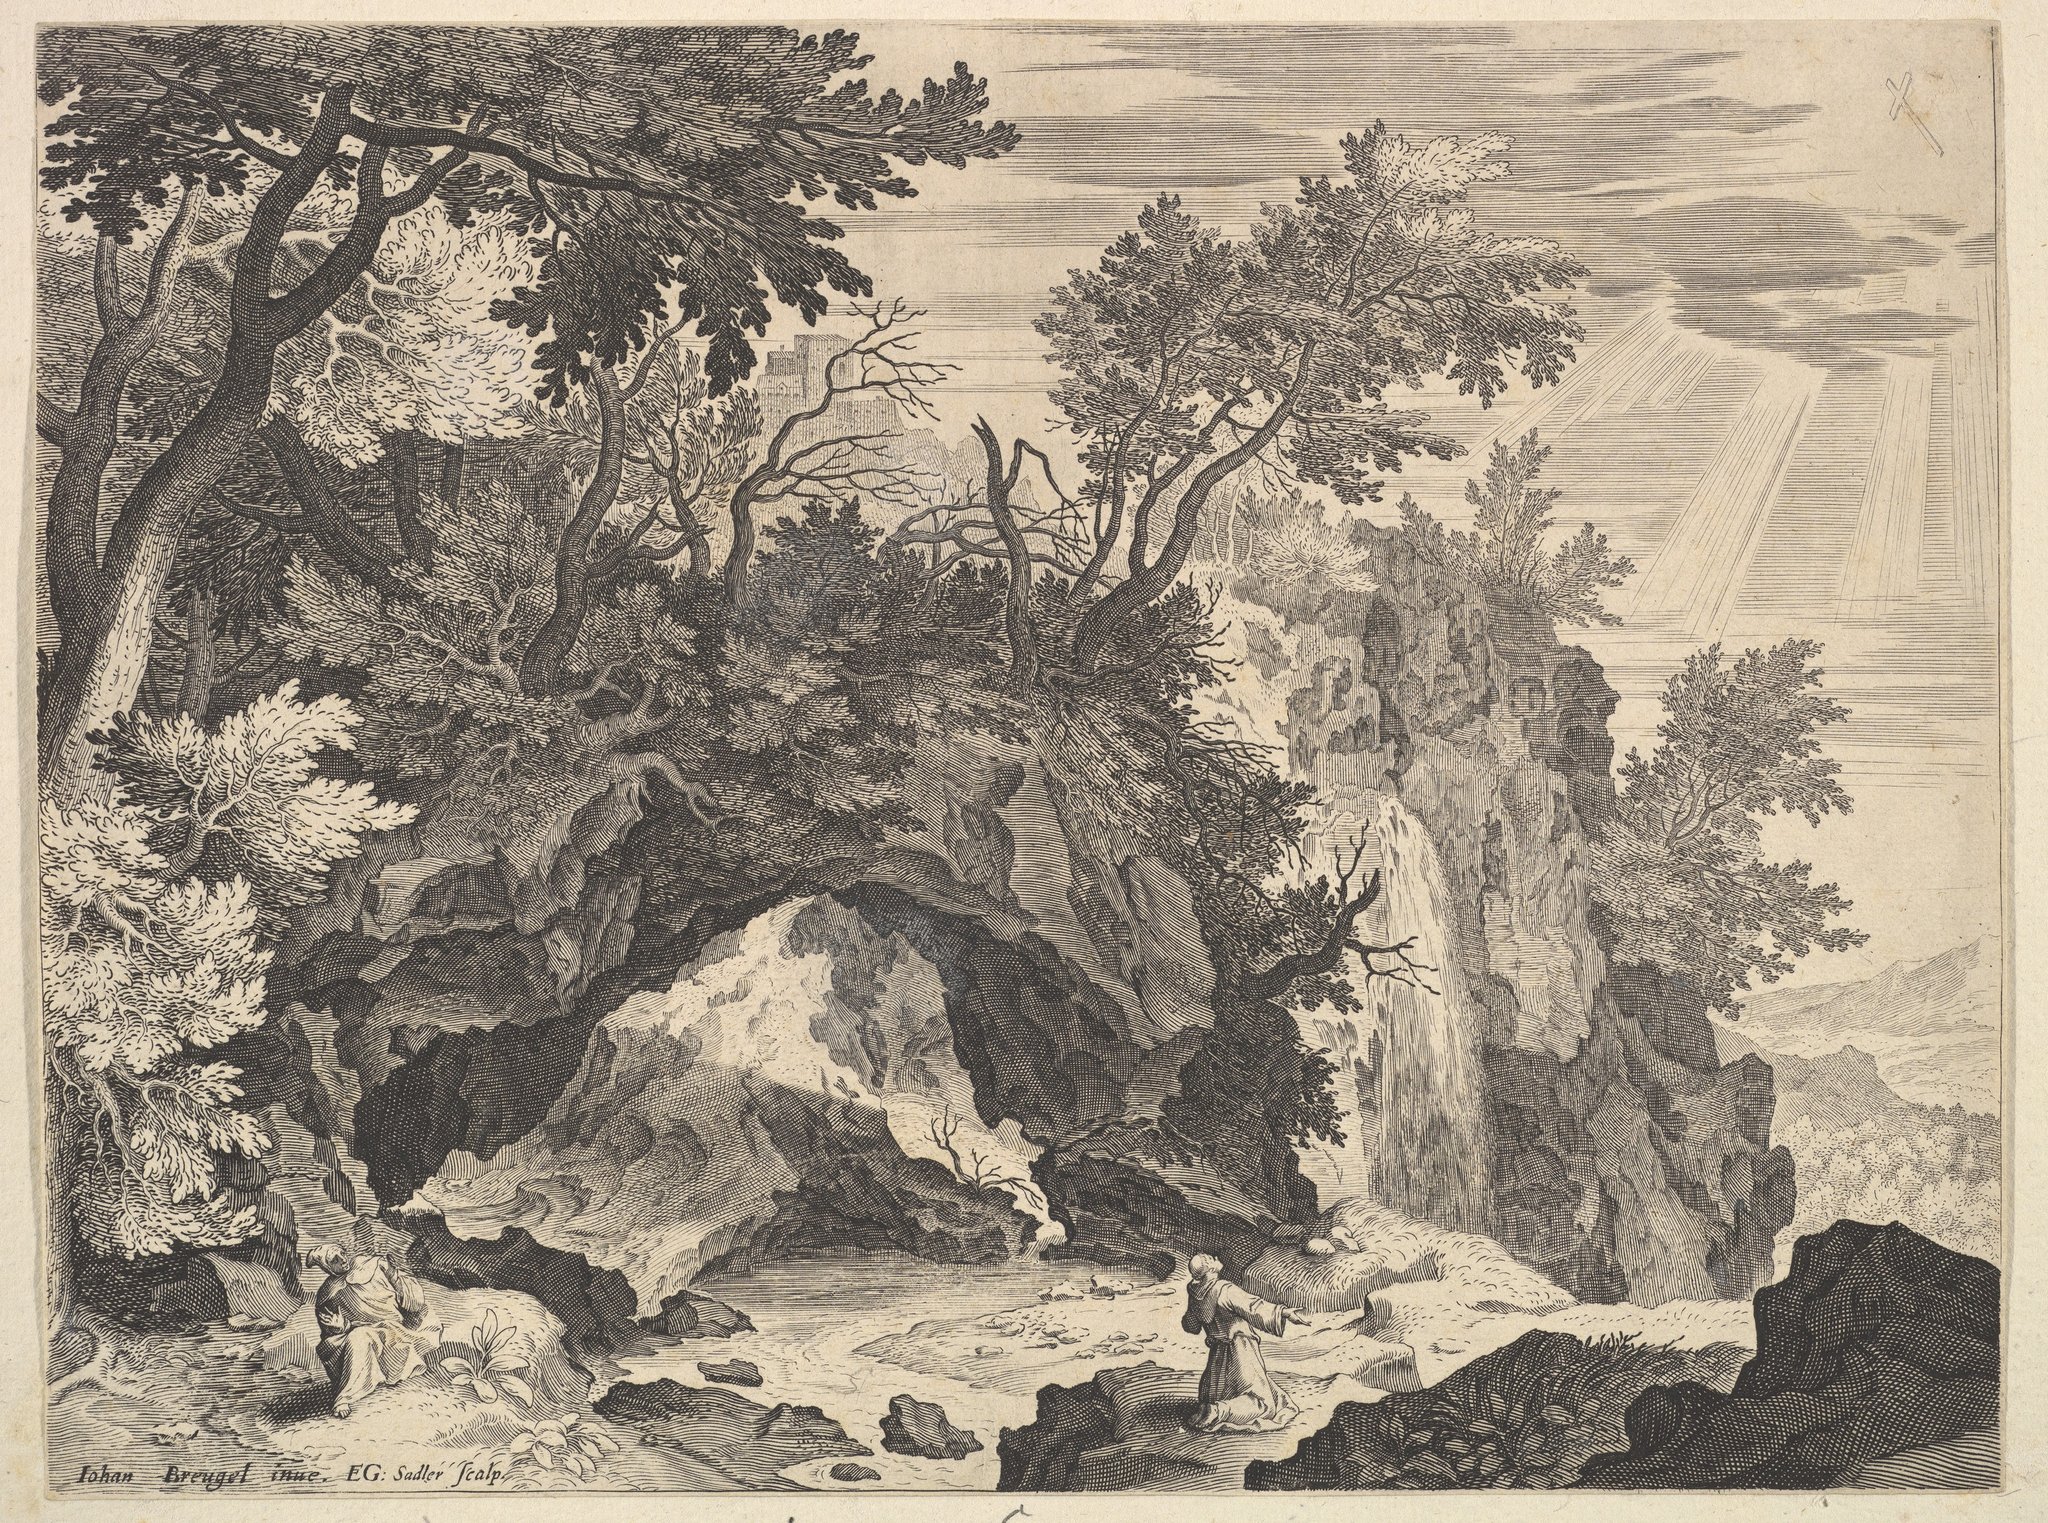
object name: print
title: Rocky Landscape with the Stigmatisation of Saint Francis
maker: aegidius sadeler (ii)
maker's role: artist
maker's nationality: flemish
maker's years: 1568-1629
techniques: engraving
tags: landscapes,trees